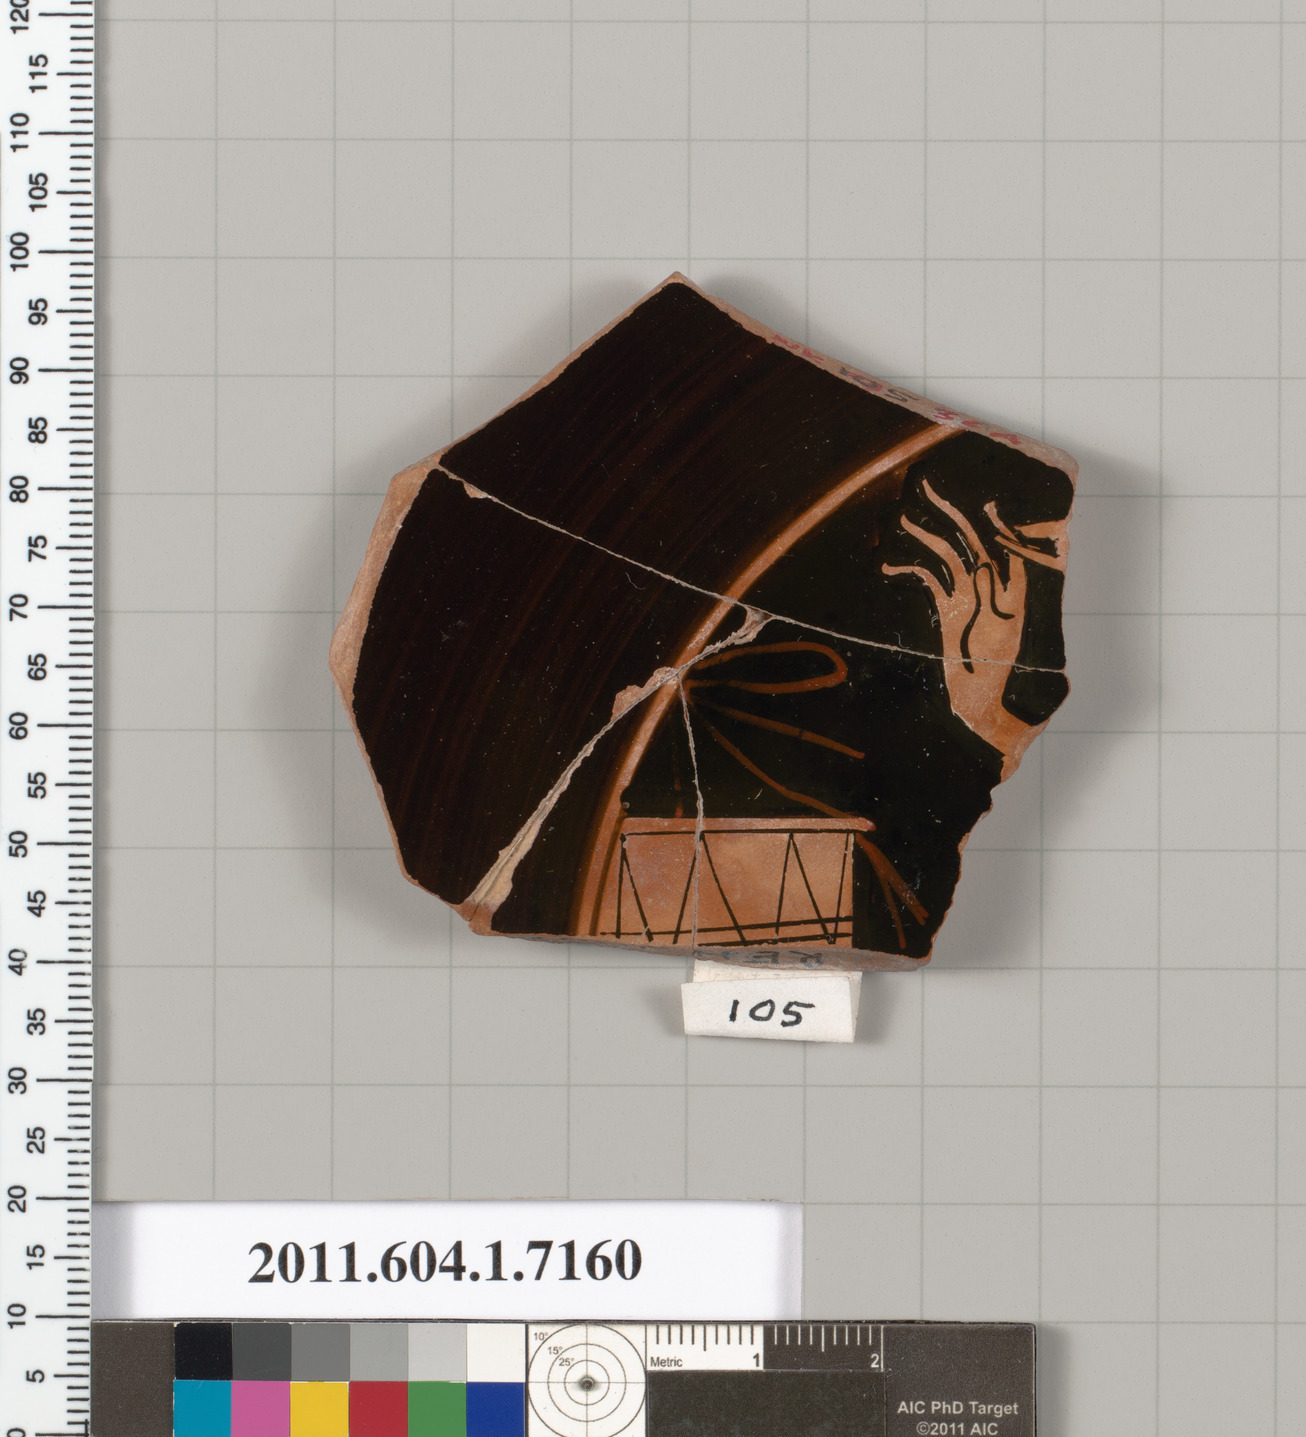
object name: kylix fragment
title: Terracotta fragment of a kylix (drinking cup)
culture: greek, attic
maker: makron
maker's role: artist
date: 500-480 BCE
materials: terracotta